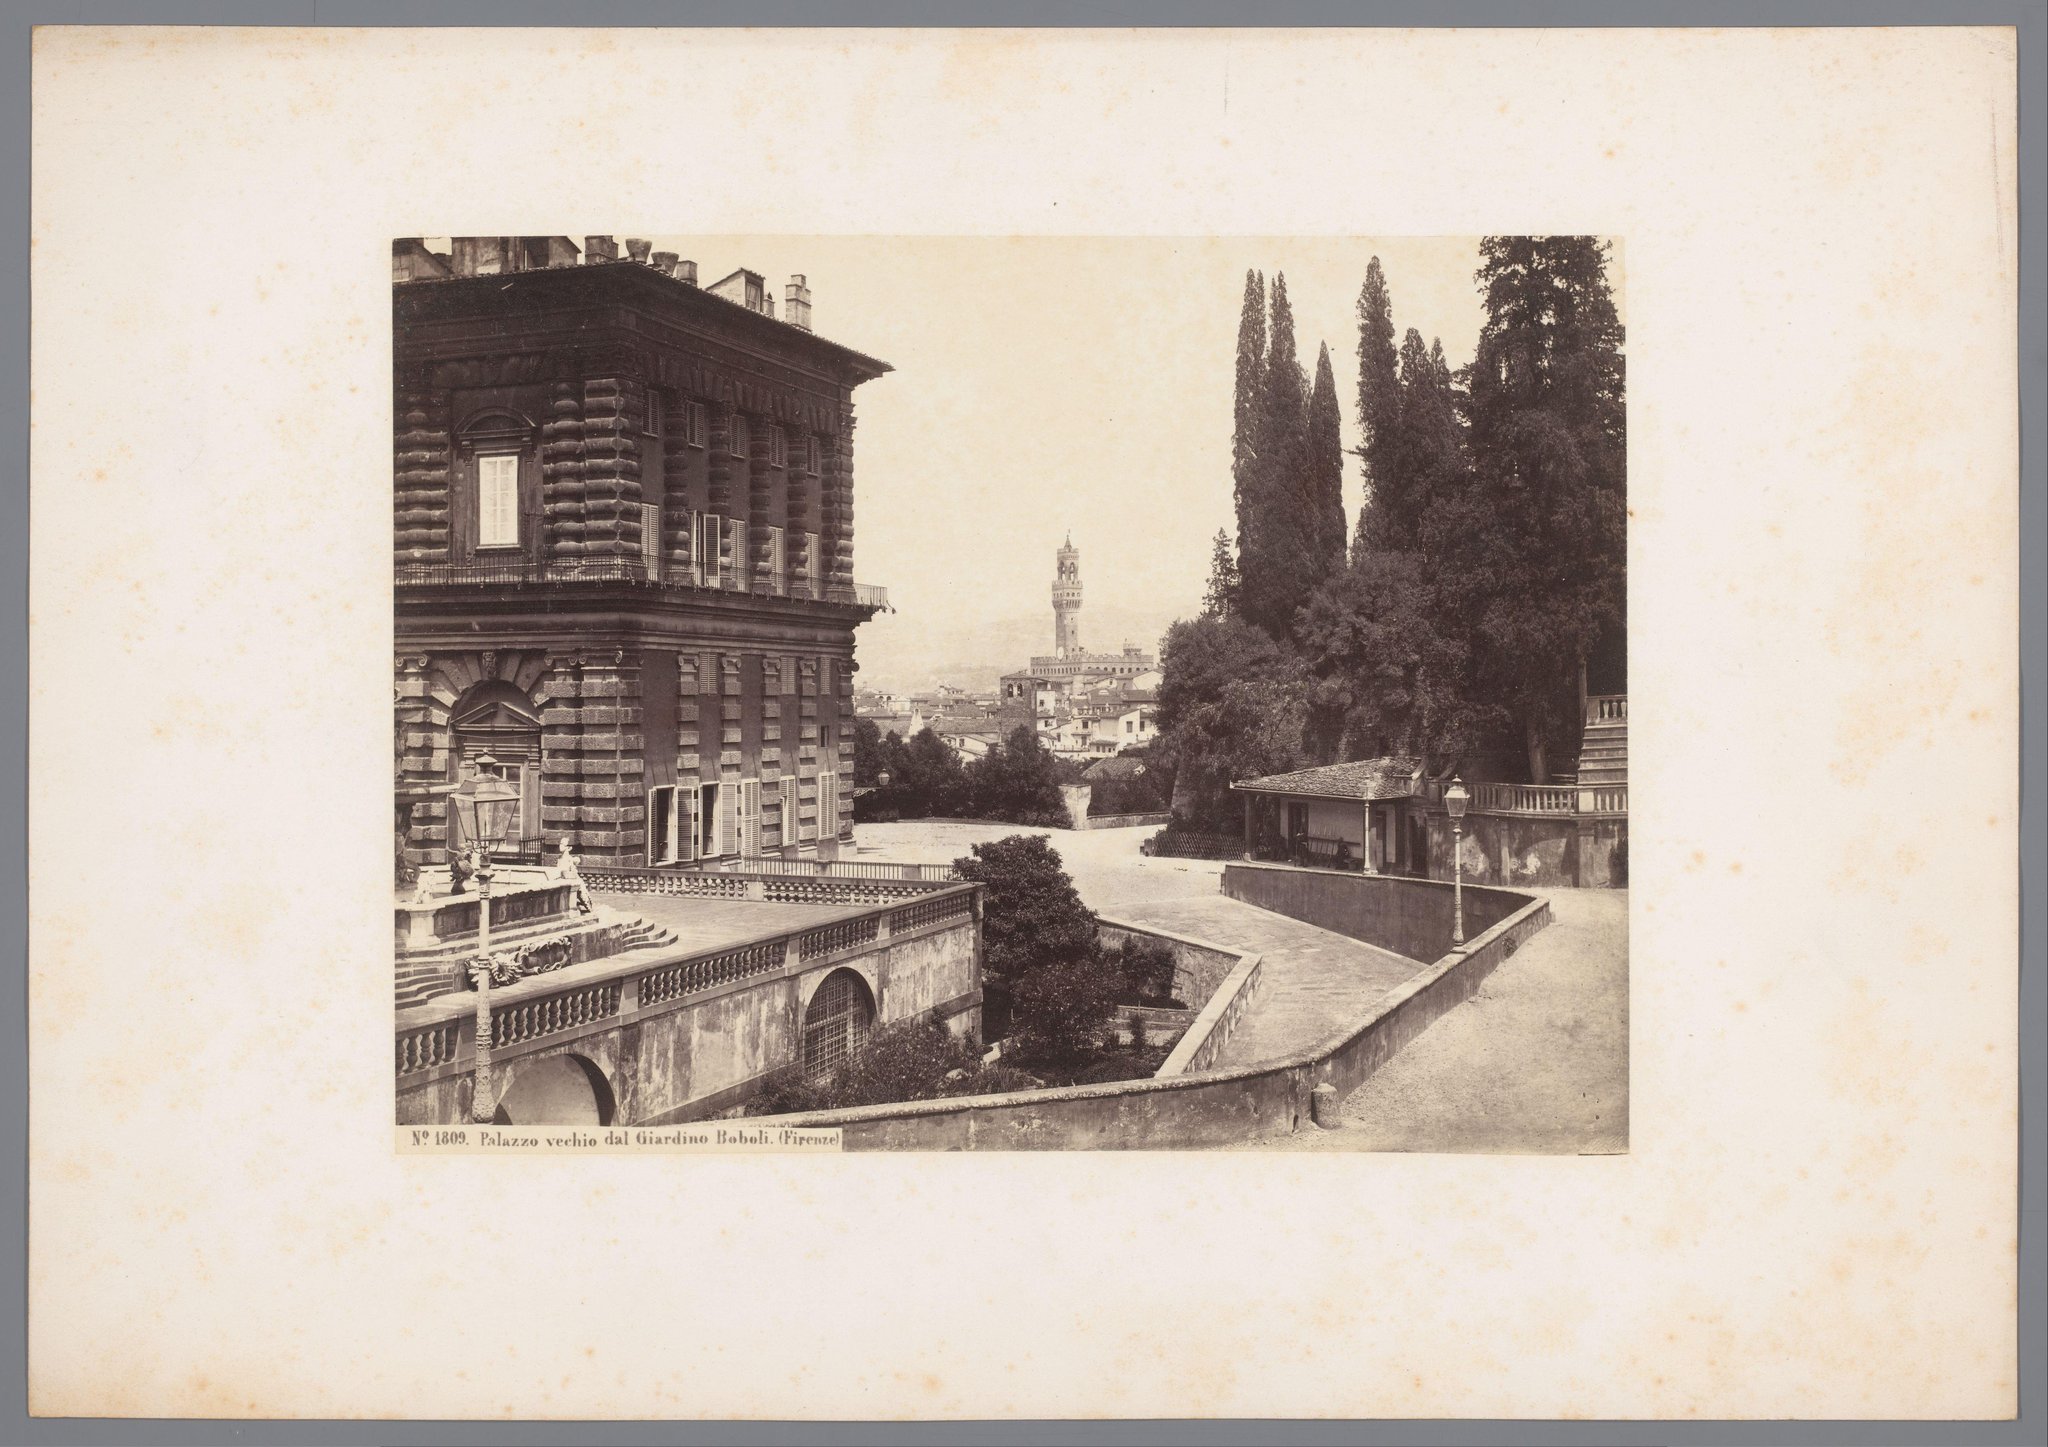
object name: photograph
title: Palazzo Vechio dal Giardino Boboli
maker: giorgio sommer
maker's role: fotograaf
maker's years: 1834-1914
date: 1863-1914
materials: cardboard, paper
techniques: albumen print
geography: florence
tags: park, hôtel, i.e. small palace in city, tower (of house or building)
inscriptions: inscription: ‘Sommer (t)’, number: ‘No. 1809’